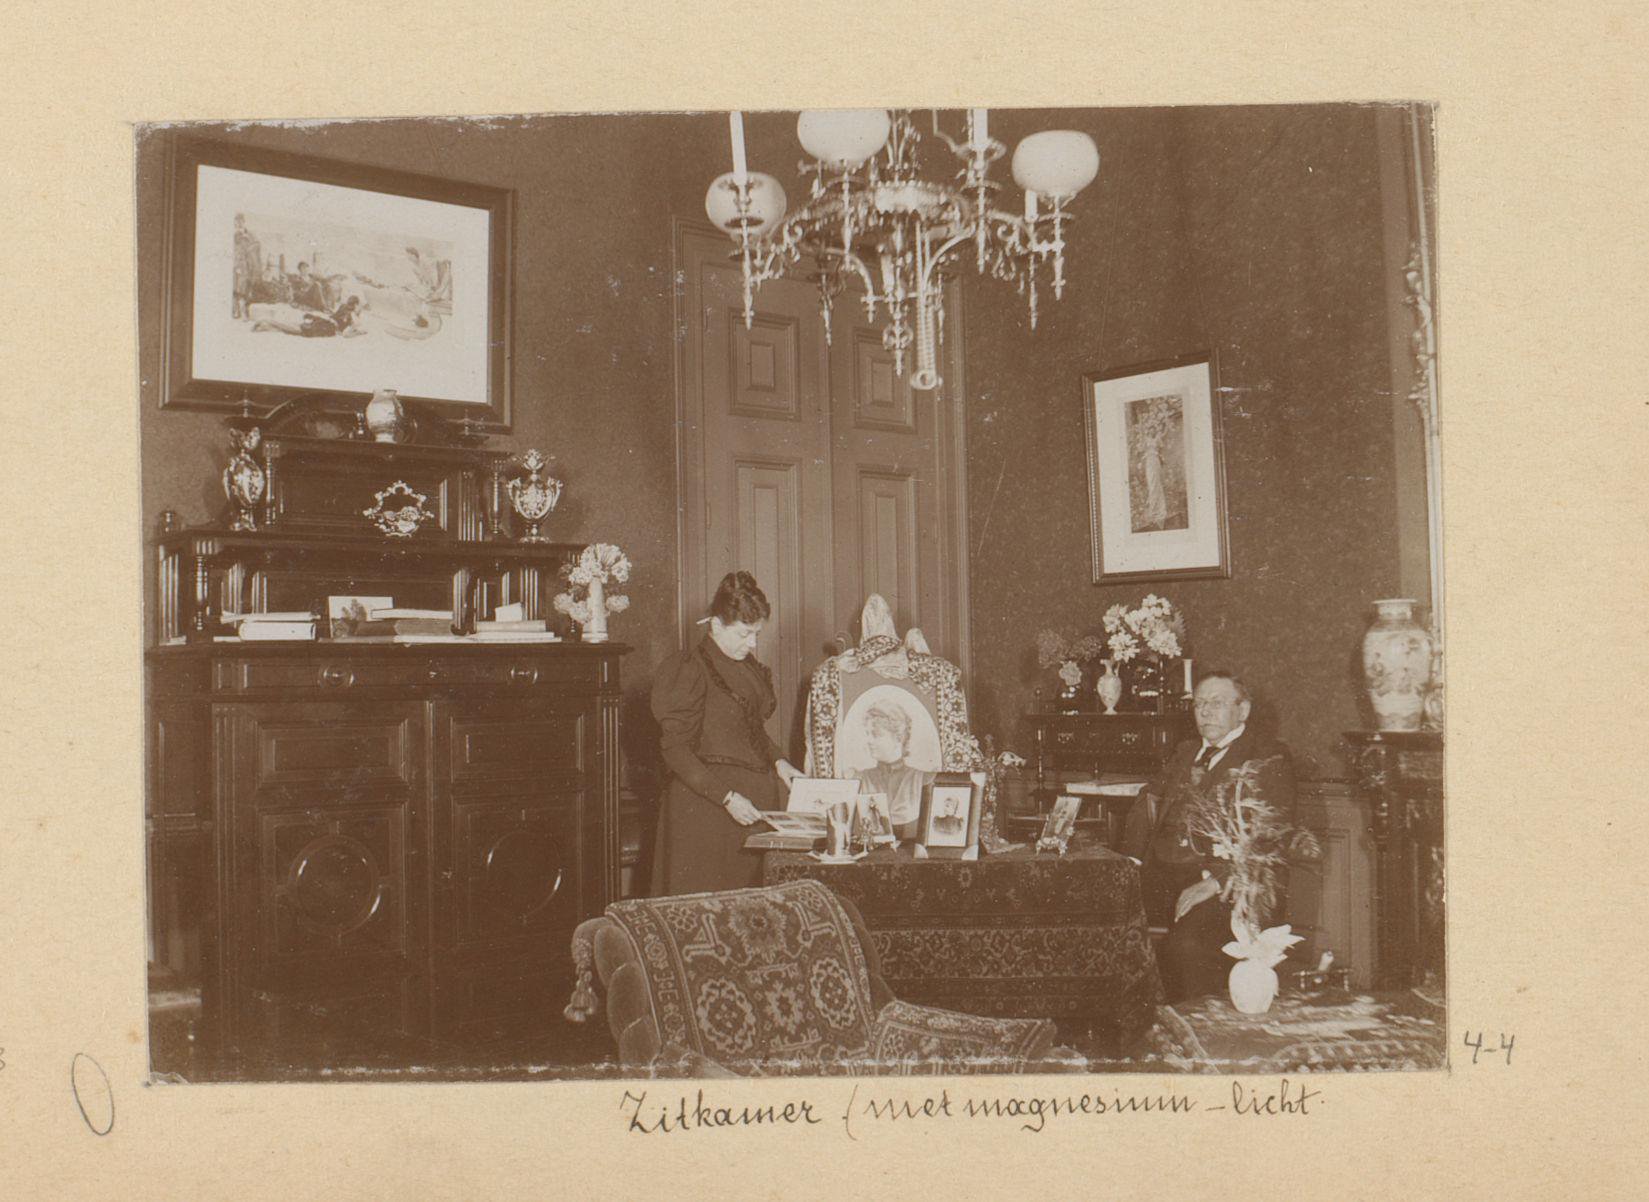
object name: photograph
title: Zitkamer (met magnesiumlicht)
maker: hendrik herman van den berg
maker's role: amateurfotograaf, jurist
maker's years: 1875-1944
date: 1890-1894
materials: paper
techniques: collodion silver print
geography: amsterdam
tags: hendrik herman van den berg, amsterdam, carolina frederika van den berg-holle, drawing-room, 'salon', historical persons, interior ~ representation of a building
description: De foto is gemaakt bij flitslicht afkomstig van bliksempoeder.